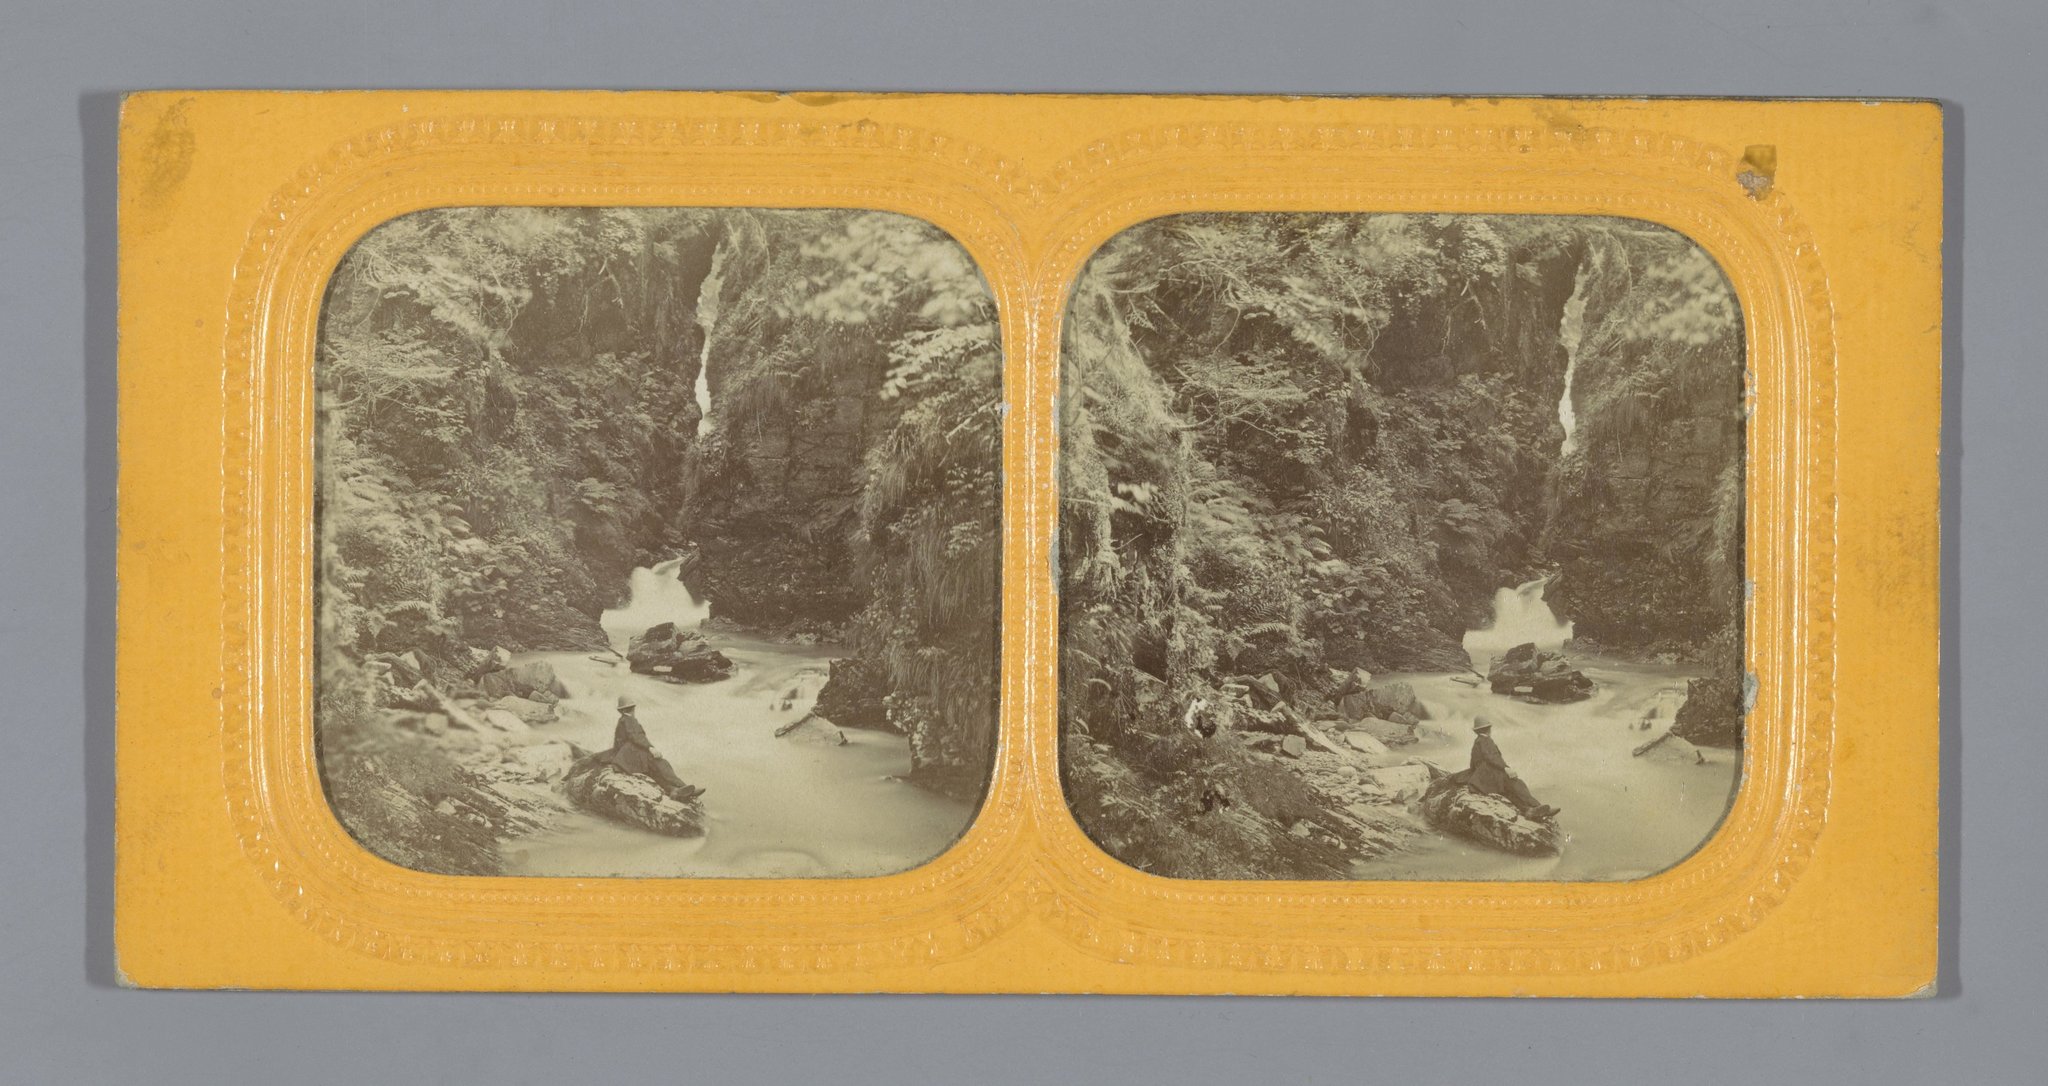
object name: tissue stereograph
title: Kloof van Gorge d'Enfer in de Pyreneeën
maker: Anonymous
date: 1855-1875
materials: cardboard, paper, photographic support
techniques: albumen print, hand coloring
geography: borce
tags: brook, ravine, chasm, abyss, canyon (+ landscape with figures, staffage)